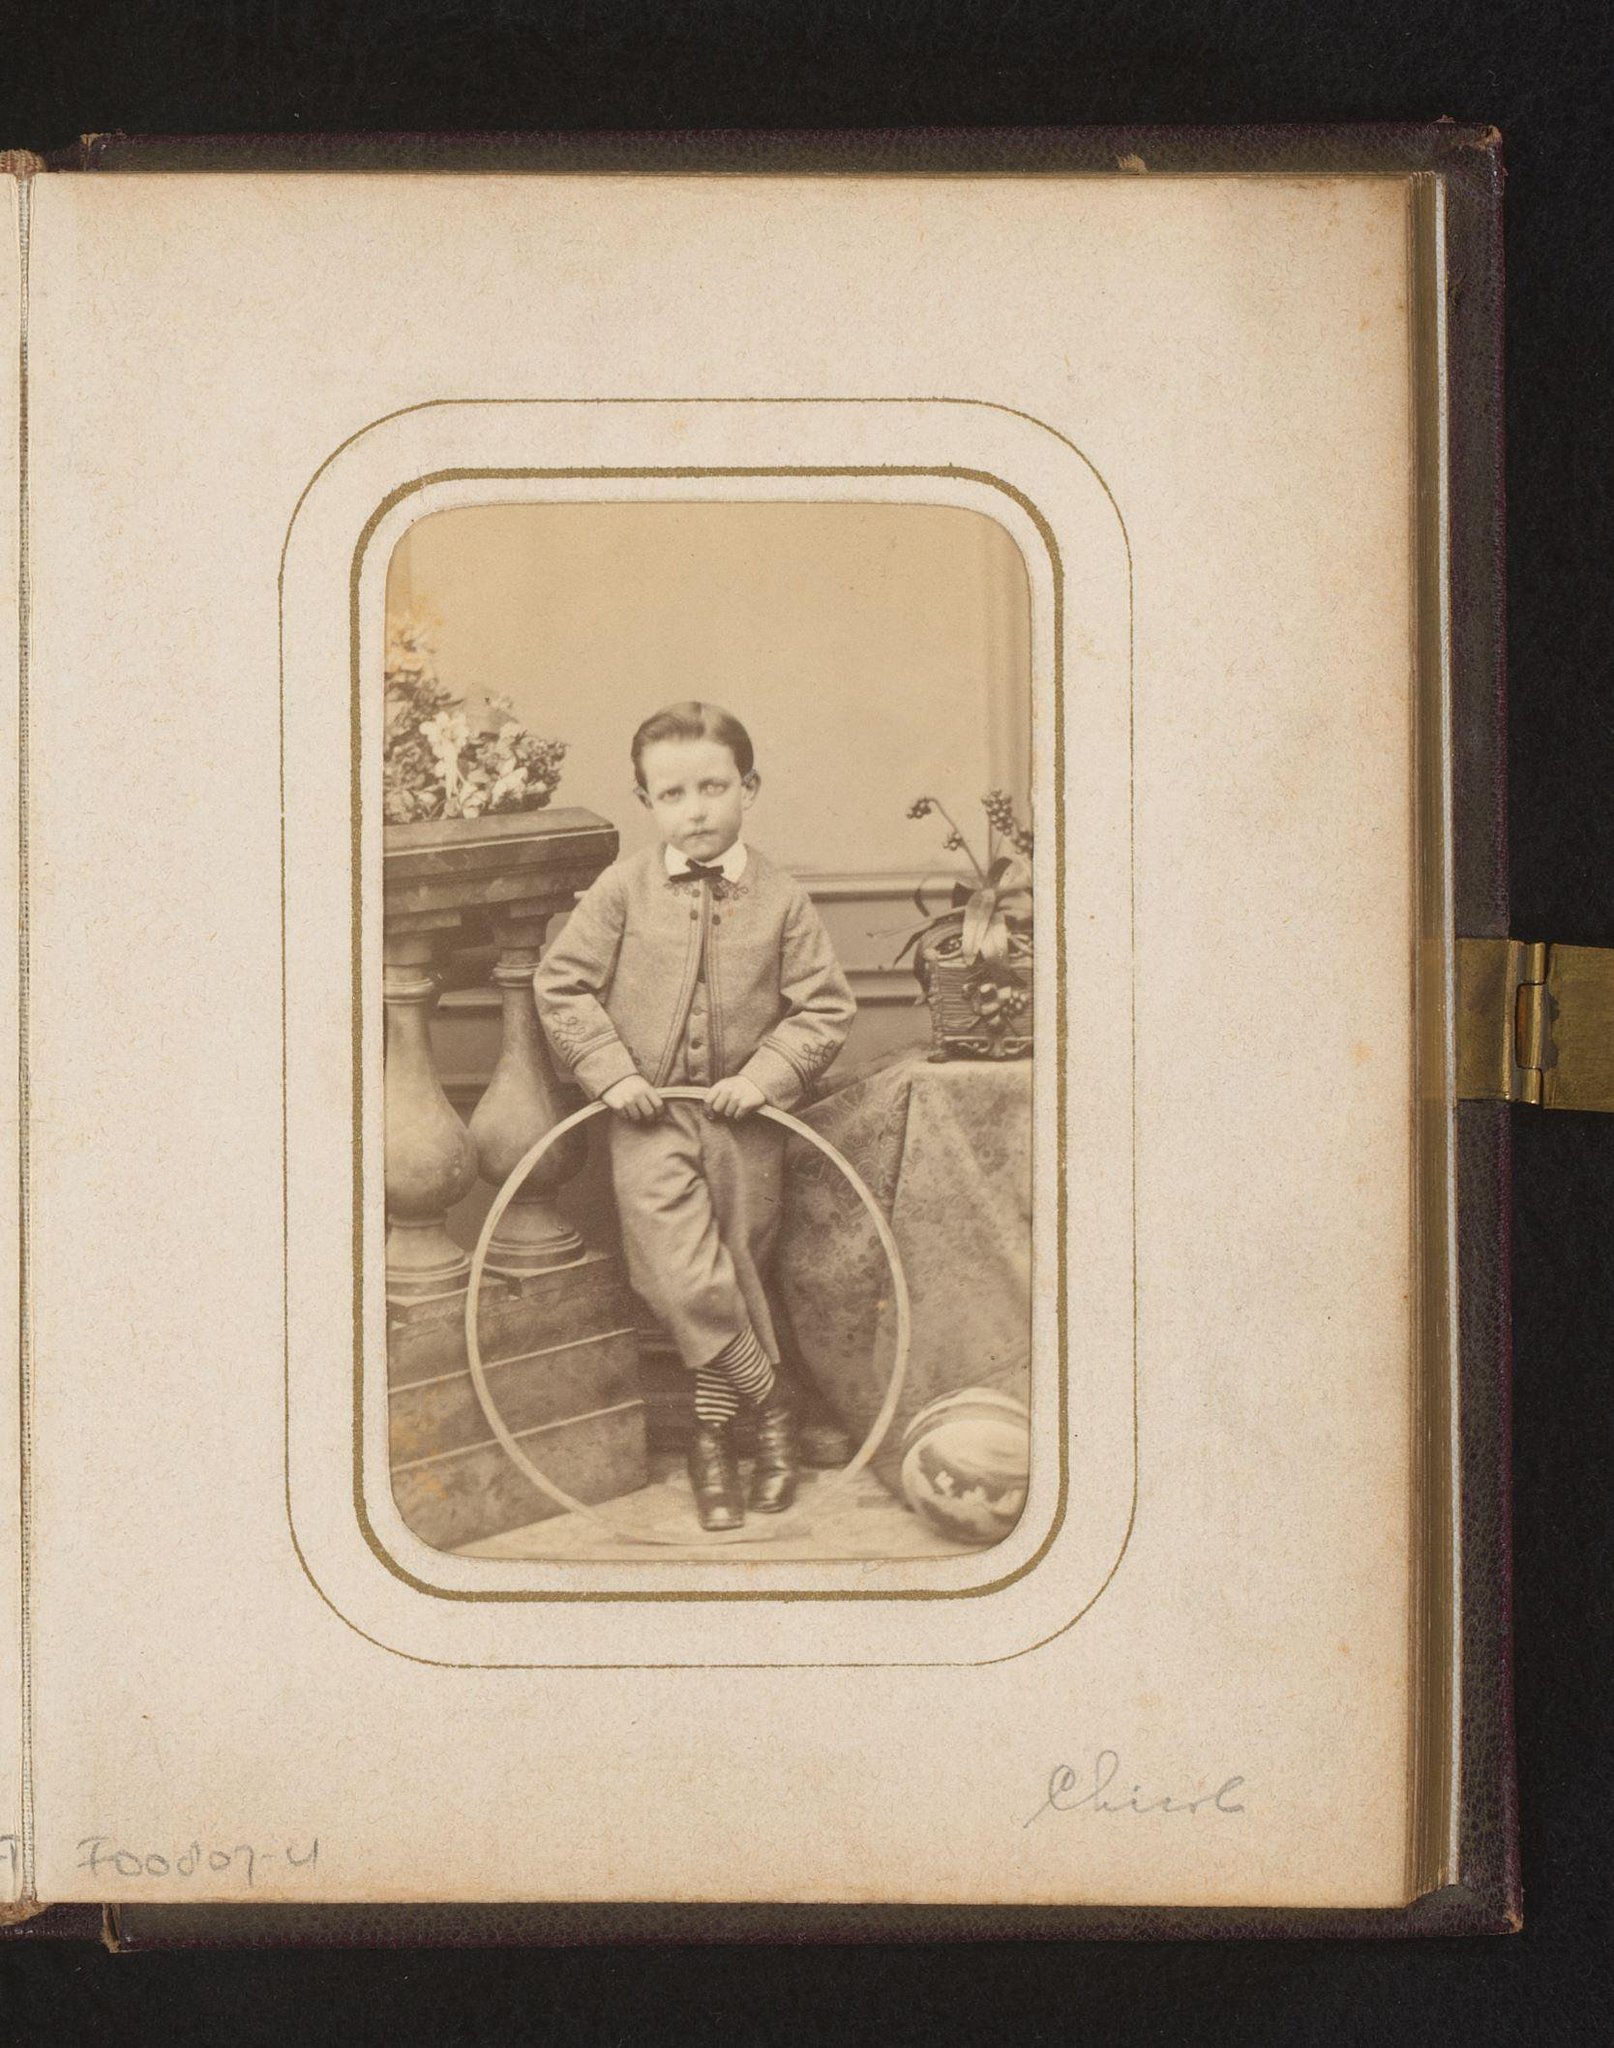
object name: carte de visite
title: Portret van een jongen met hoepel in de hand, staand bij een balustrade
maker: f. chirot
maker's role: fotograaf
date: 1860-1880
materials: cardboard, photographic support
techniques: albumen print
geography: paris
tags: boy (child between toddler and youth), historical persons, balustrade, (bowling a) hoop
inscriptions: inscription: ‘Fne. Chirot/ 160 R.St Martin 160/ Paris’, annotation: ‘Chirot’